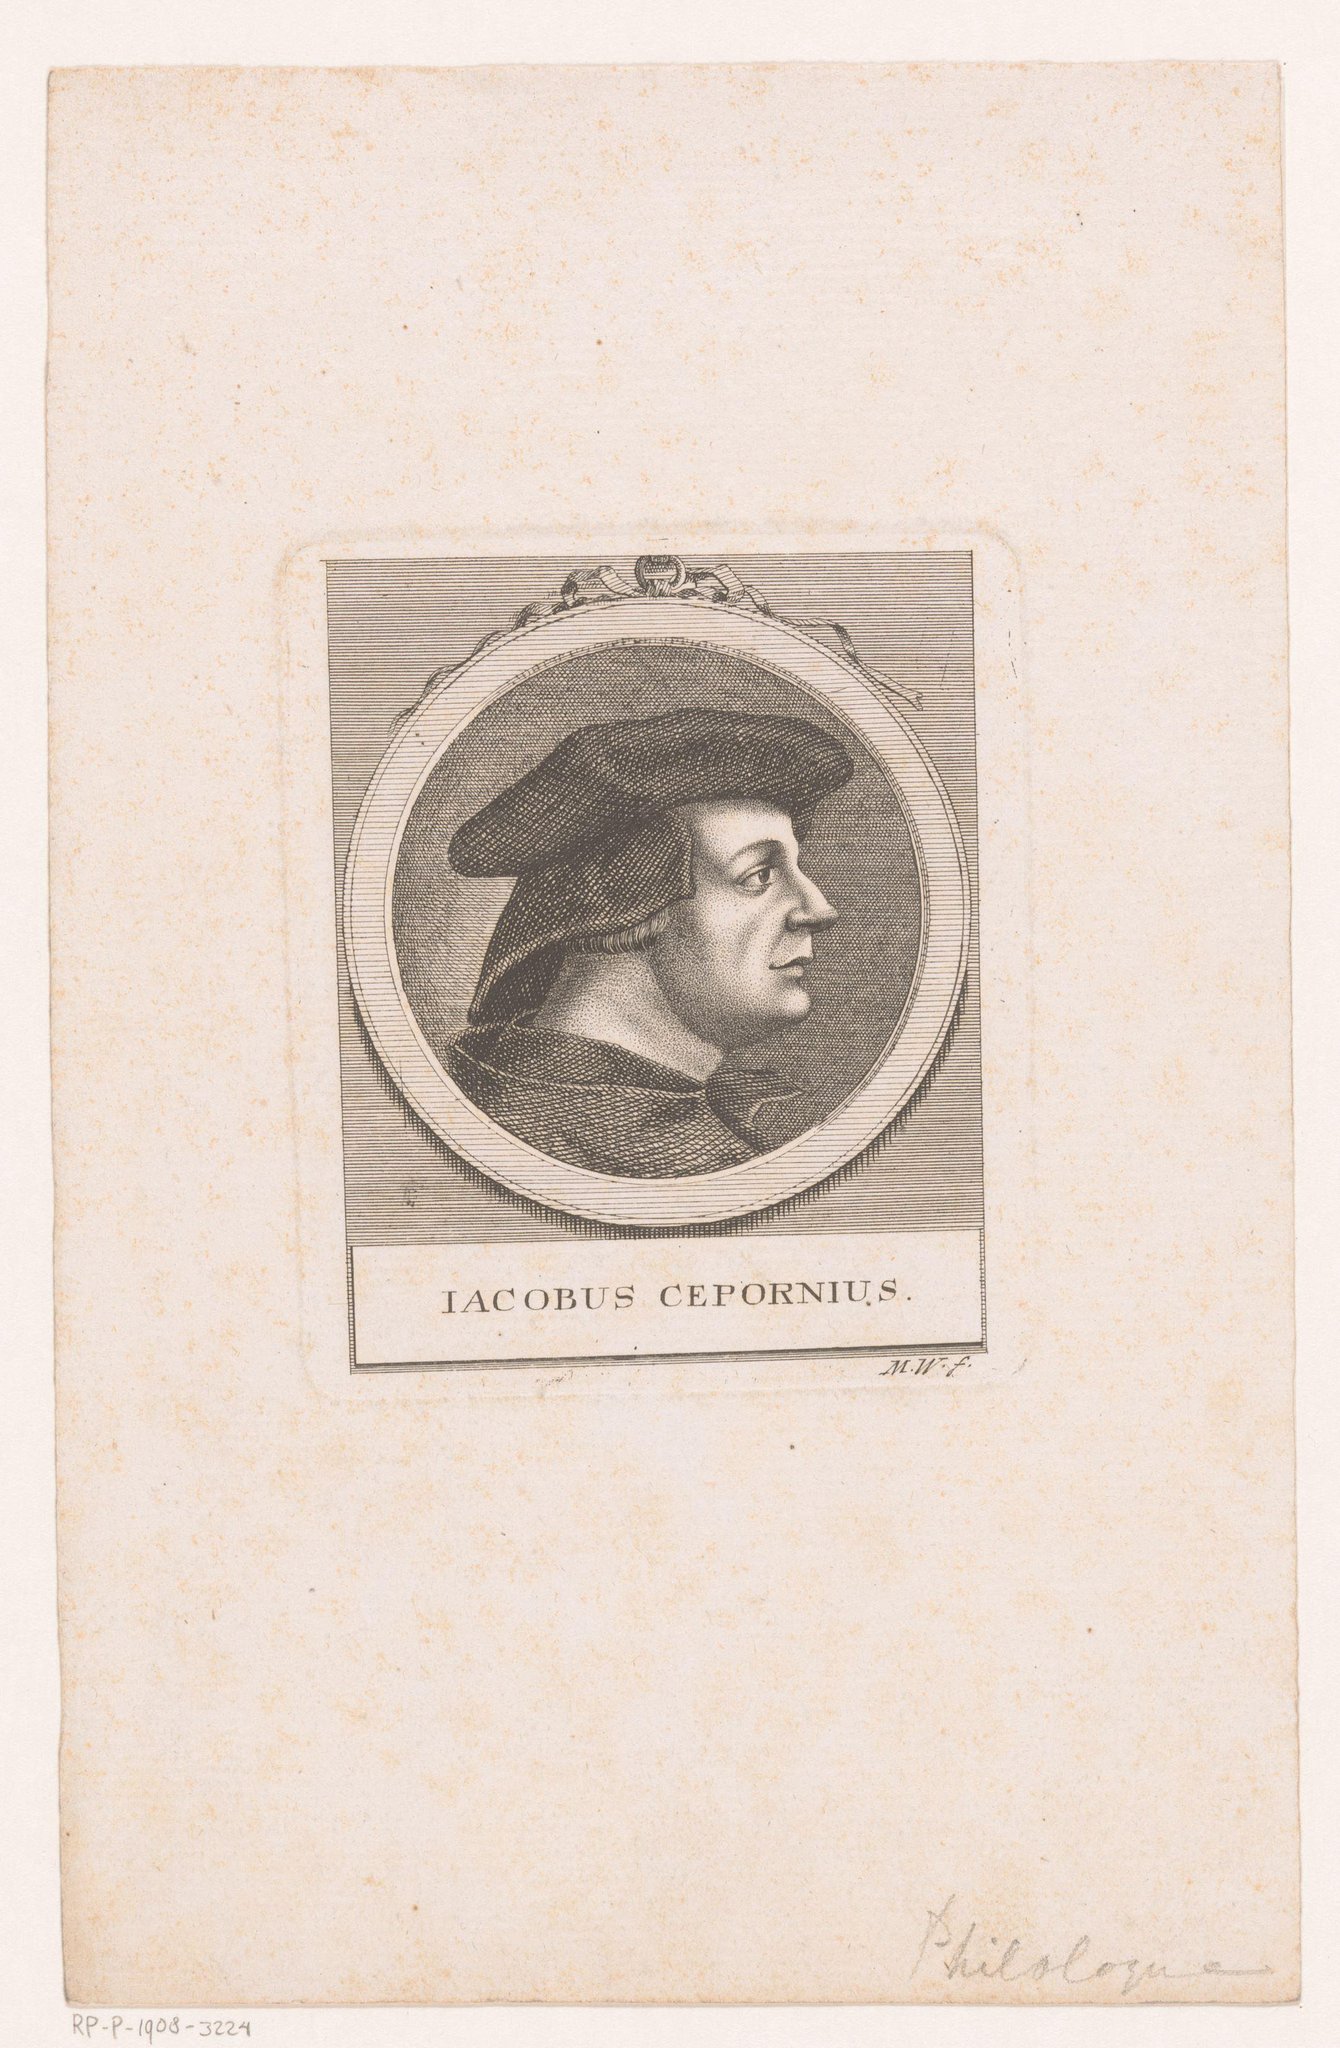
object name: print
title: Portret van Jakob Ceporinus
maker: marquard wocher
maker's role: painter, print maker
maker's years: 1760-1830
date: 1770-1830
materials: paper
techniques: engraving, etching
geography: switzerland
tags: historical persons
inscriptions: collector's mark: Lugt 2228